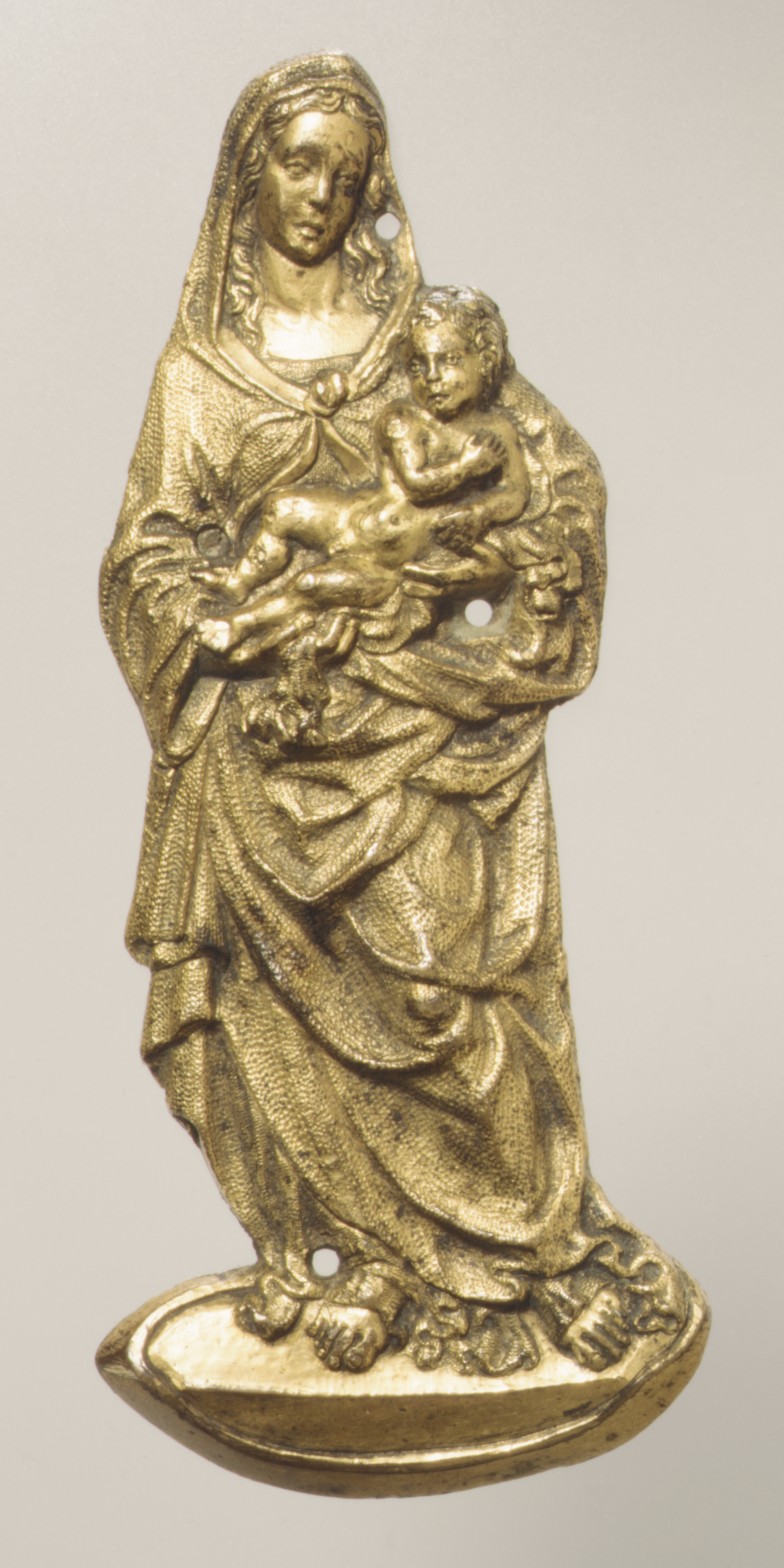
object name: relief statuette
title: Virgin and Child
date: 1467-1500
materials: gilt bronze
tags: madonna and child